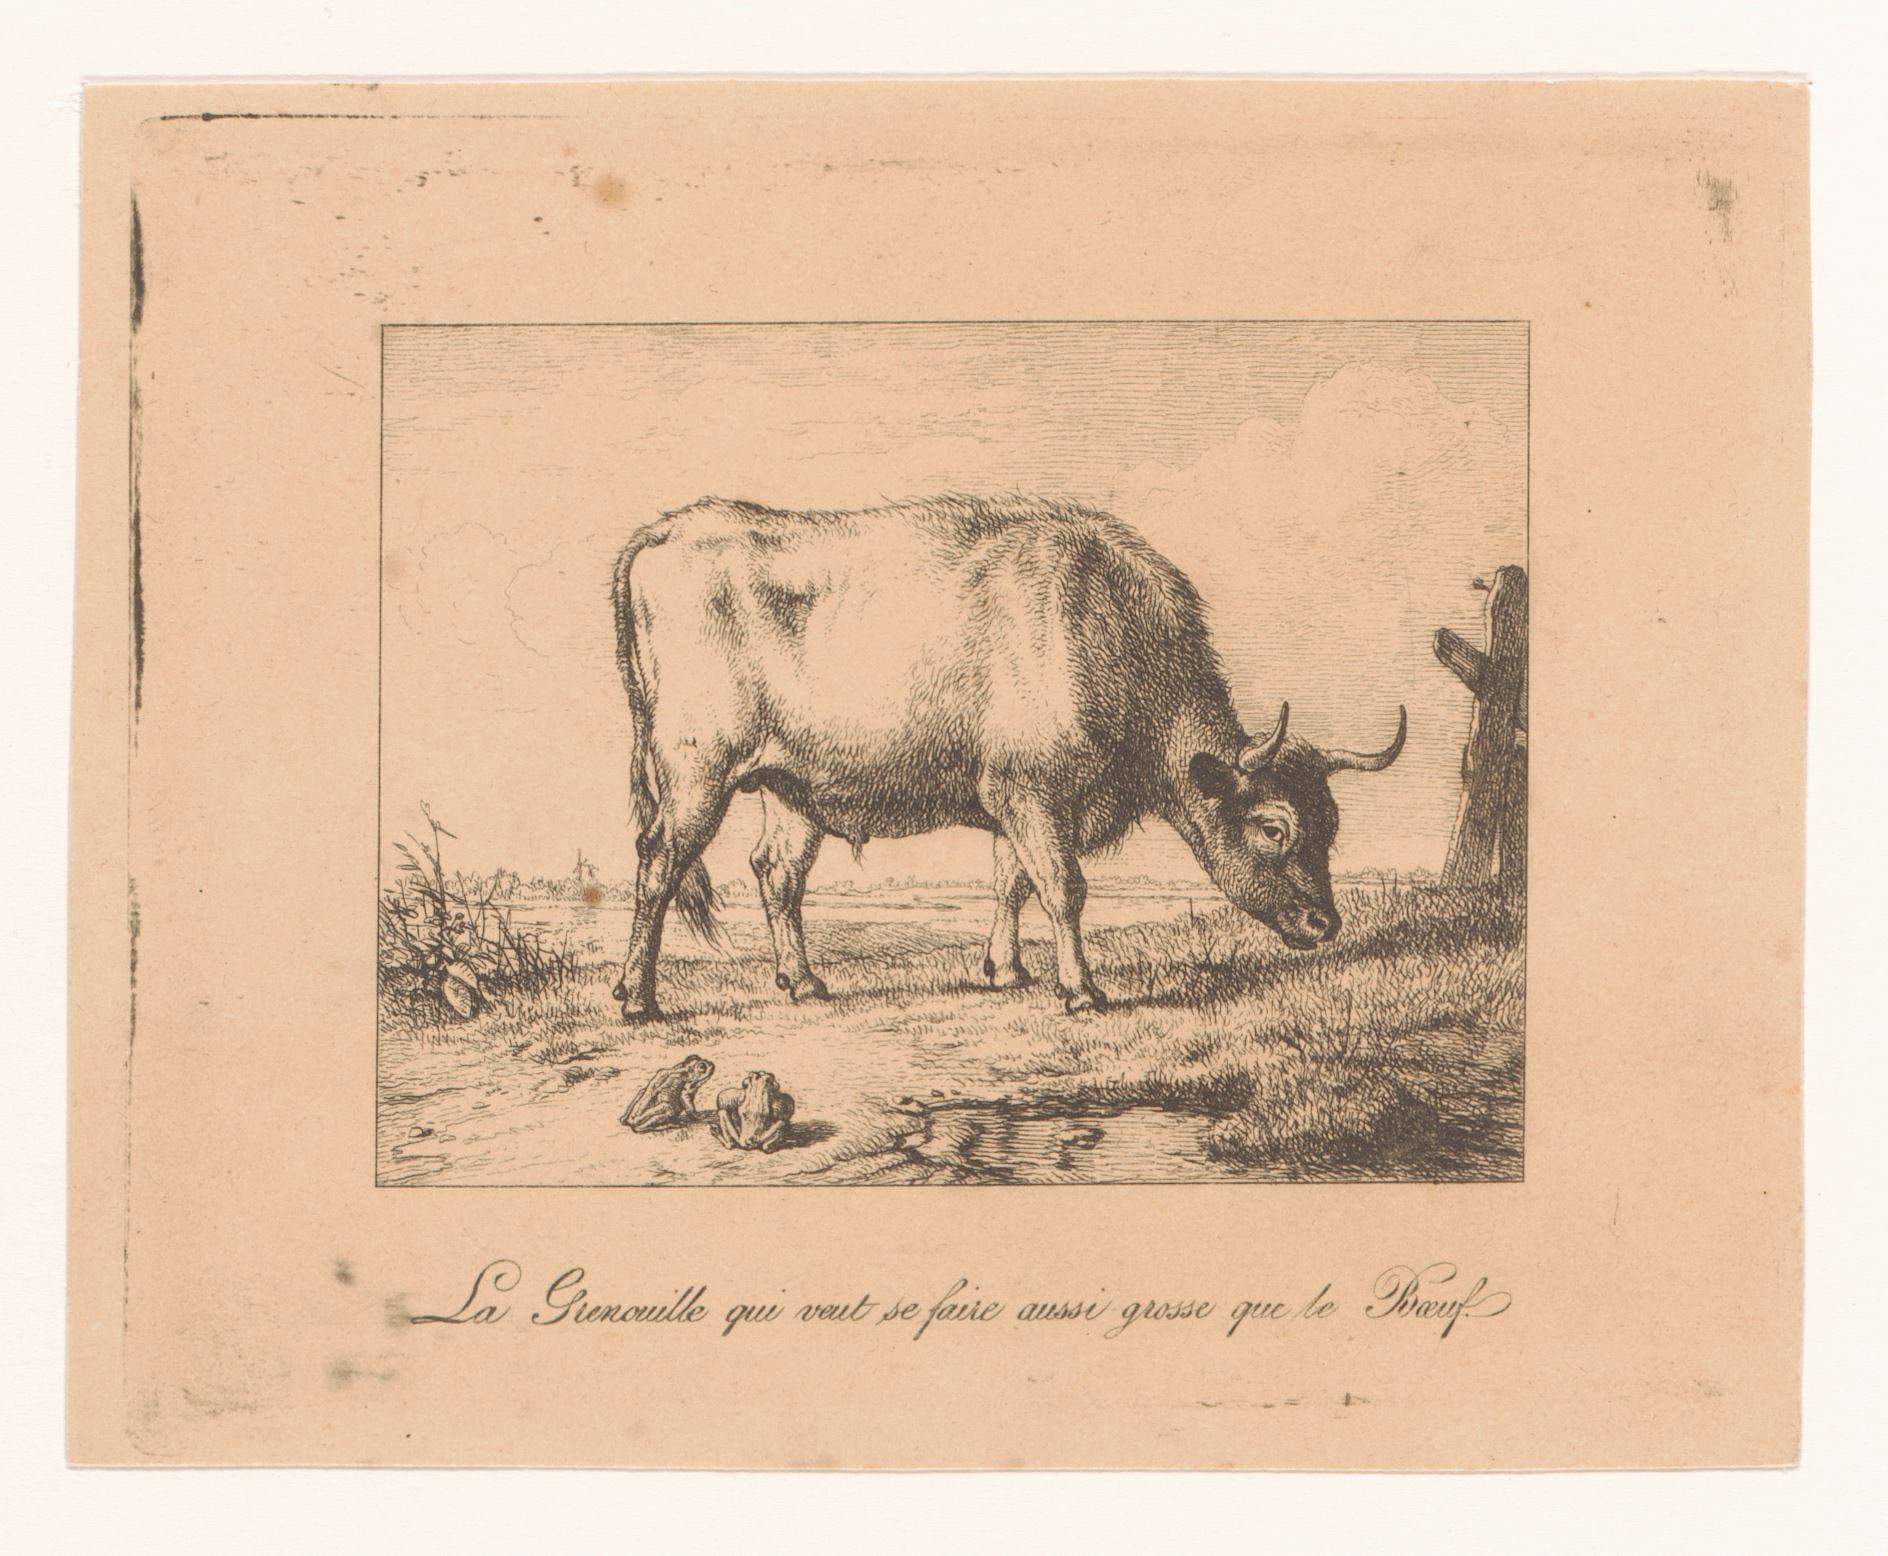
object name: print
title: Fabels van La Fontaine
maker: eugène verboeckhoven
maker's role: draughtsman, painter, print maker, printer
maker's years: 1798-1881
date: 1830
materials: paper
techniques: etching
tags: tailless amphibians: frog, fable of the frog and the cow, cow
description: Prent maakt deel uit van een serie van acht prenten met scènes uit de fabels van Jean de La Fontaine.